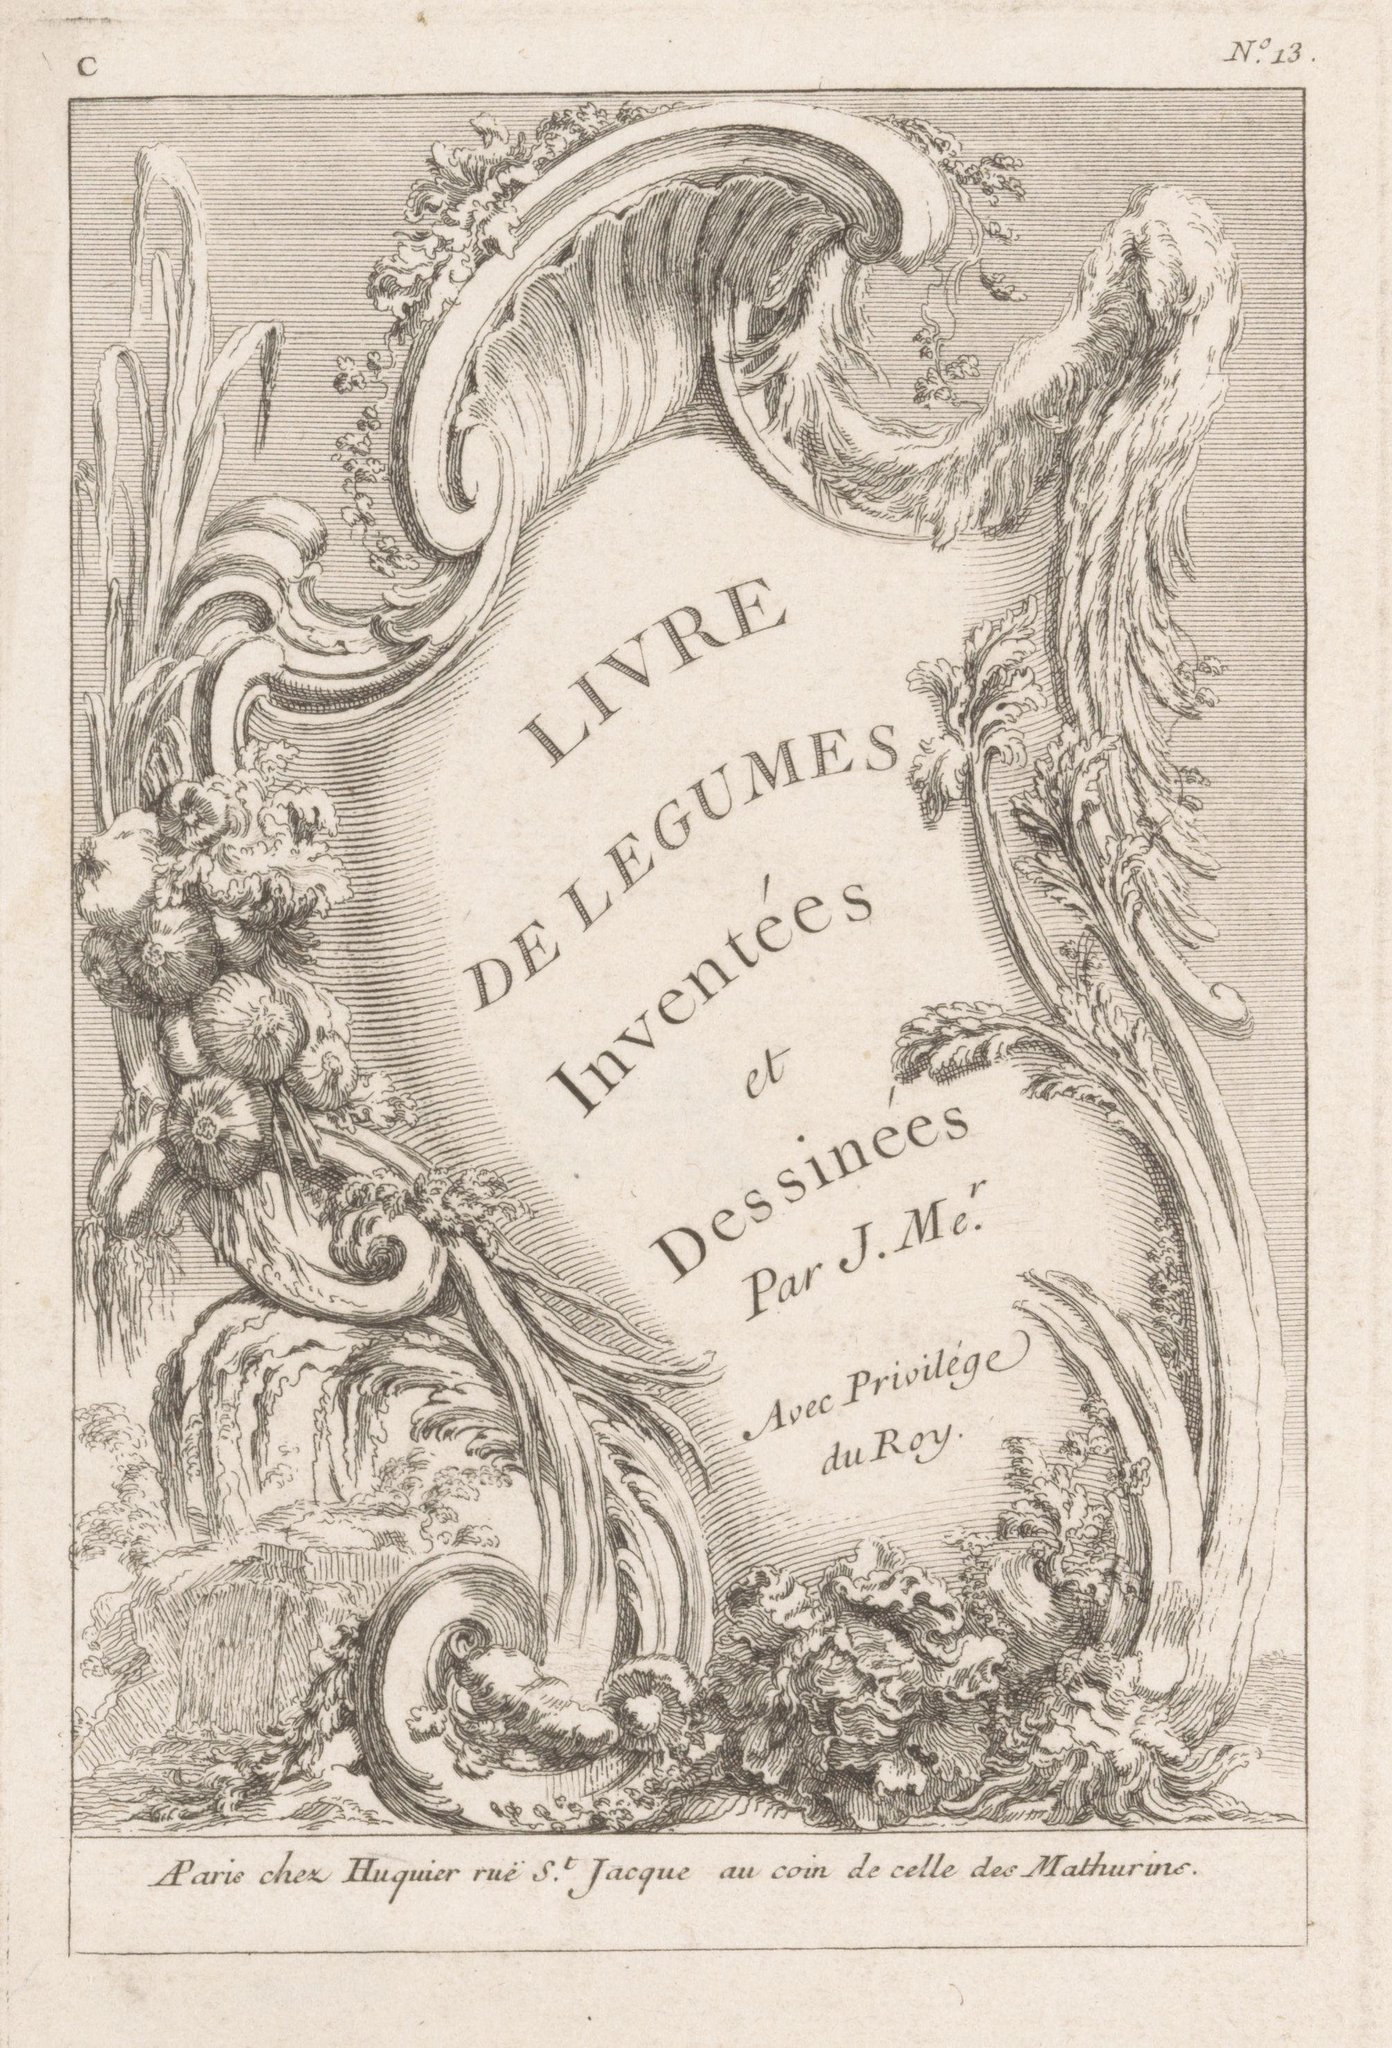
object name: print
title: Cartouche met groente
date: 1738-1749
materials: paper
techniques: etching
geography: paris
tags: vegetables, ornament ~ cartouche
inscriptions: collector's mark: Lugt 2228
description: Een rocaille cartouche met de serietitel omgeven door bladeren en groente. Prentnummer 13.